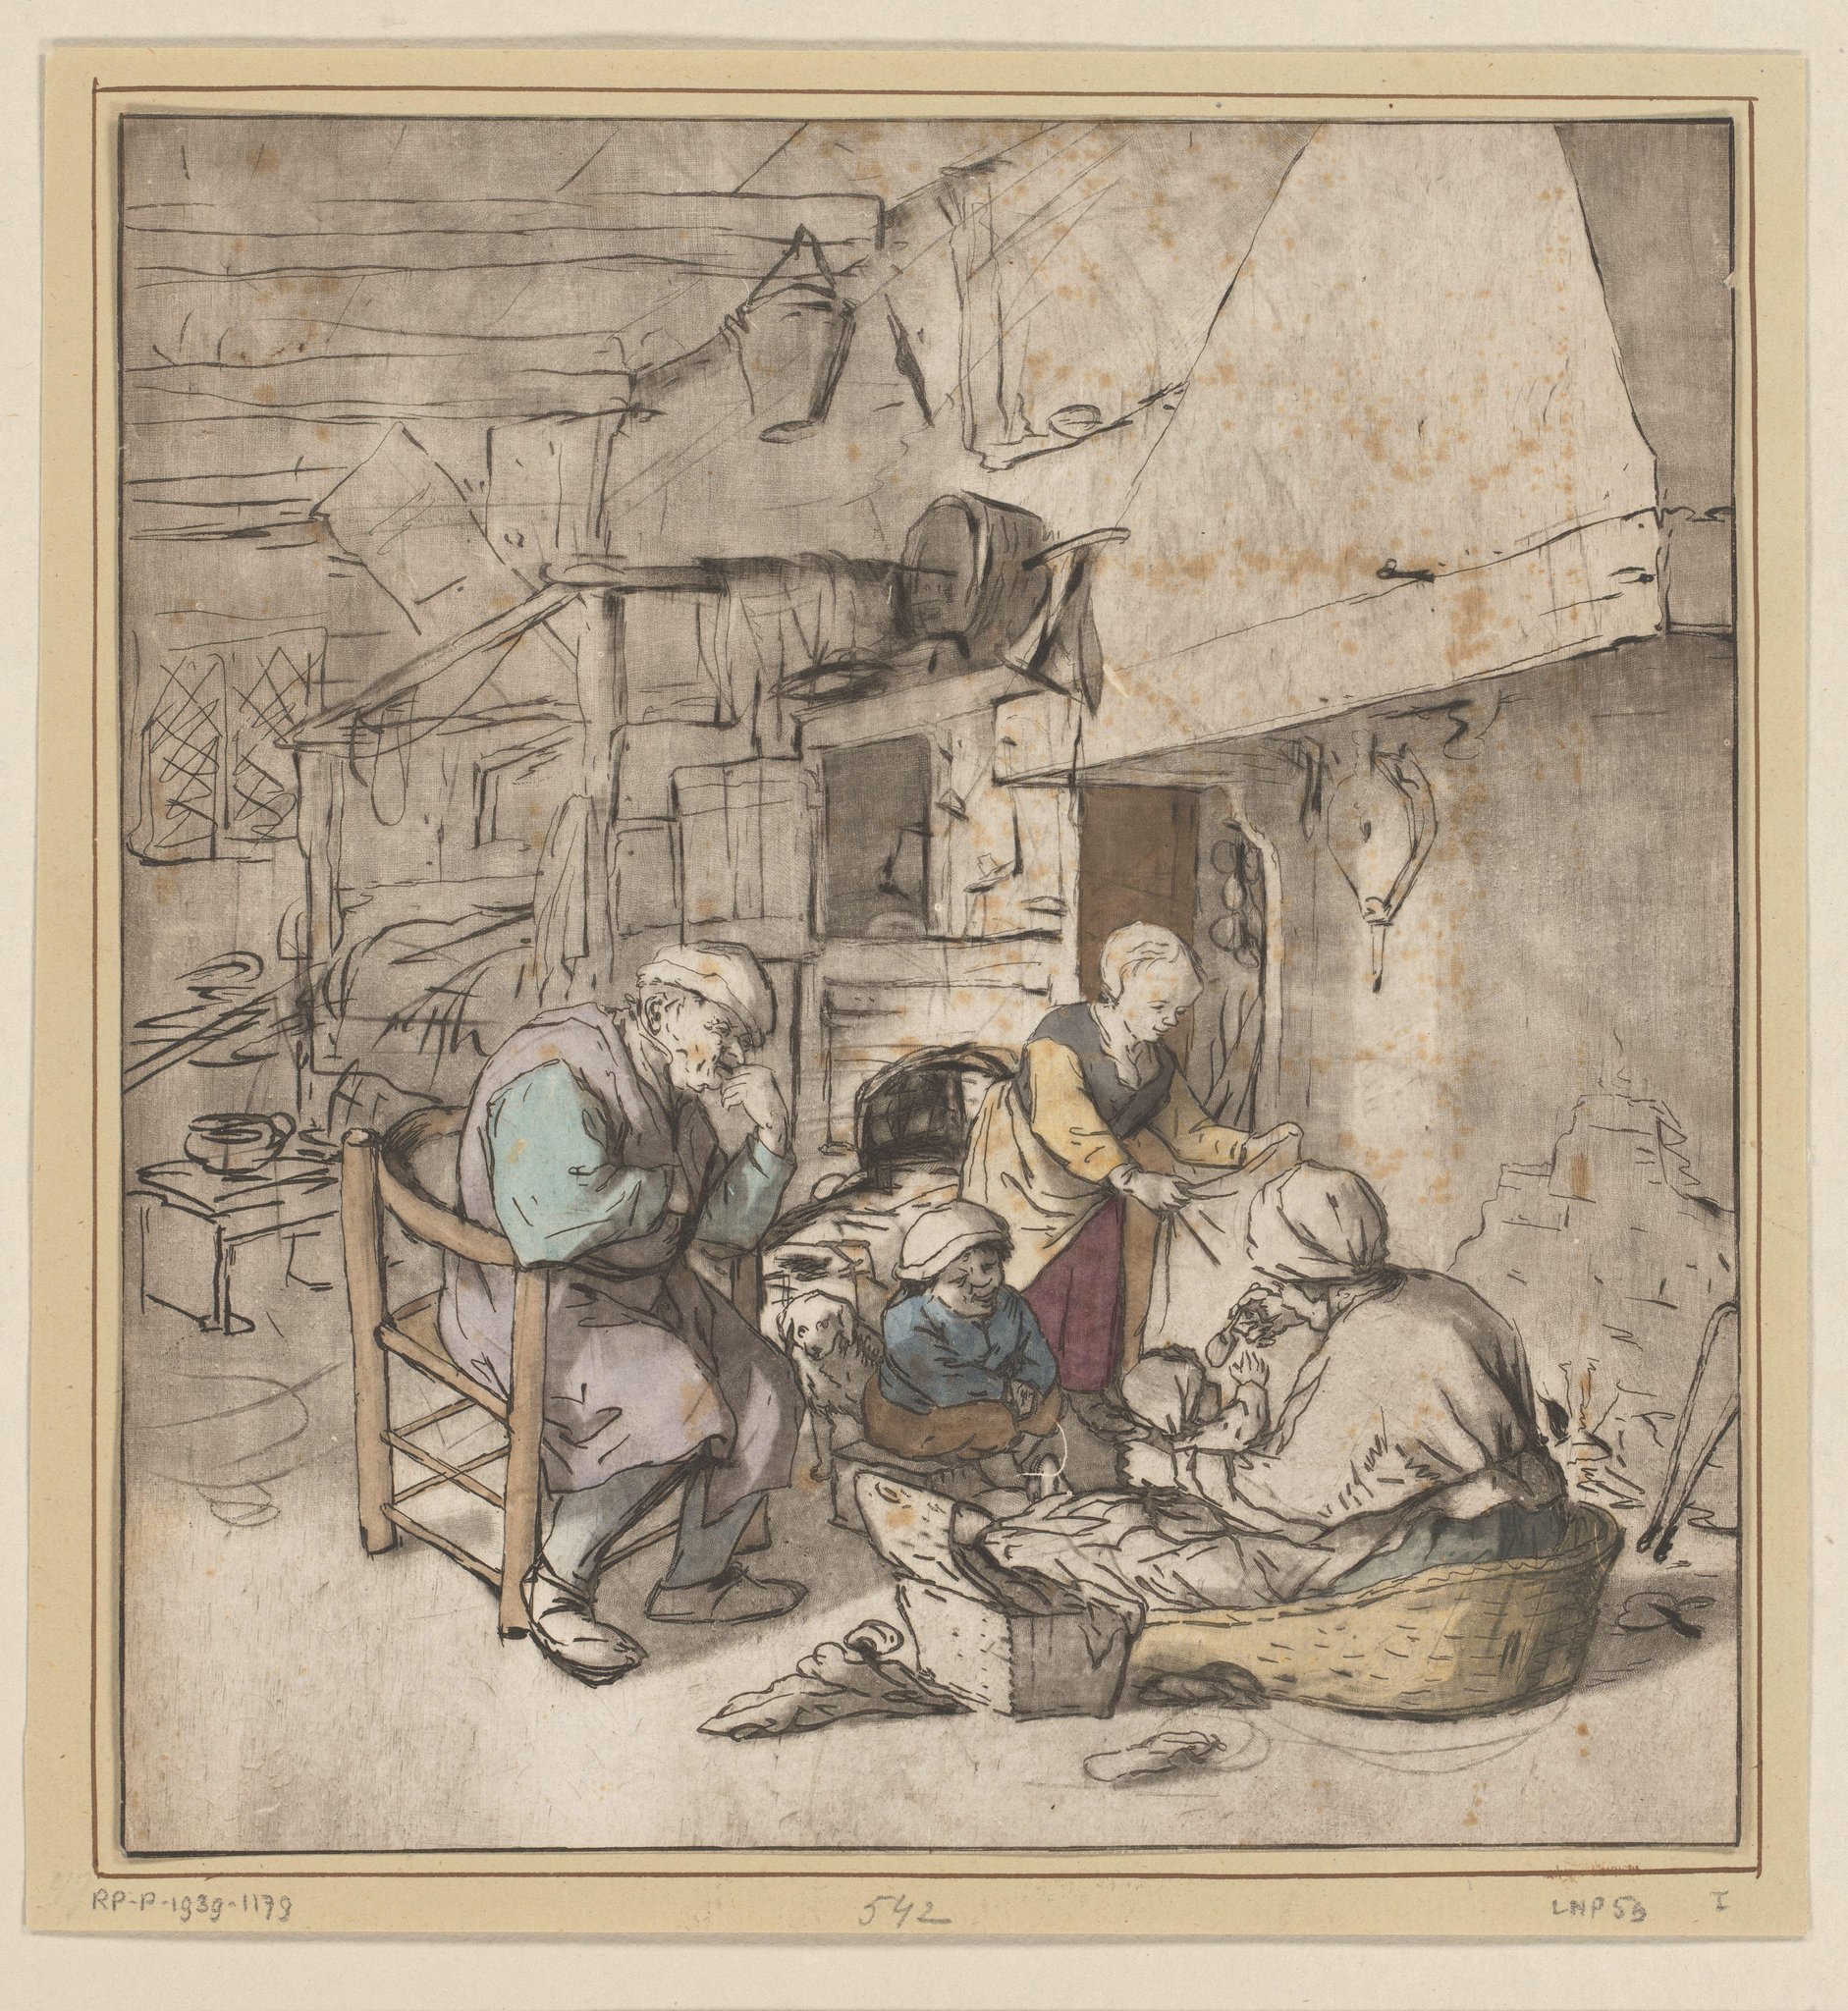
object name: print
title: Boerengezin bij schoorsteen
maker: cornelis ploos van amstel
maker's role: draughtsman, print maker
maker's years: 1726-1798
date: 1767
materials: paper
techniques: etching, hand coloring, roulette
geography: amsterdam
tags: open hearth, fire-place, interior of the house, family life at home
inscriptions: collector's mark: ‘RIJKS / MUSM’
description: Interieur met een gezin rond de schoorsteen. Een moeder voedt haar baby. De prent ligt los in een album, zie blad 59.